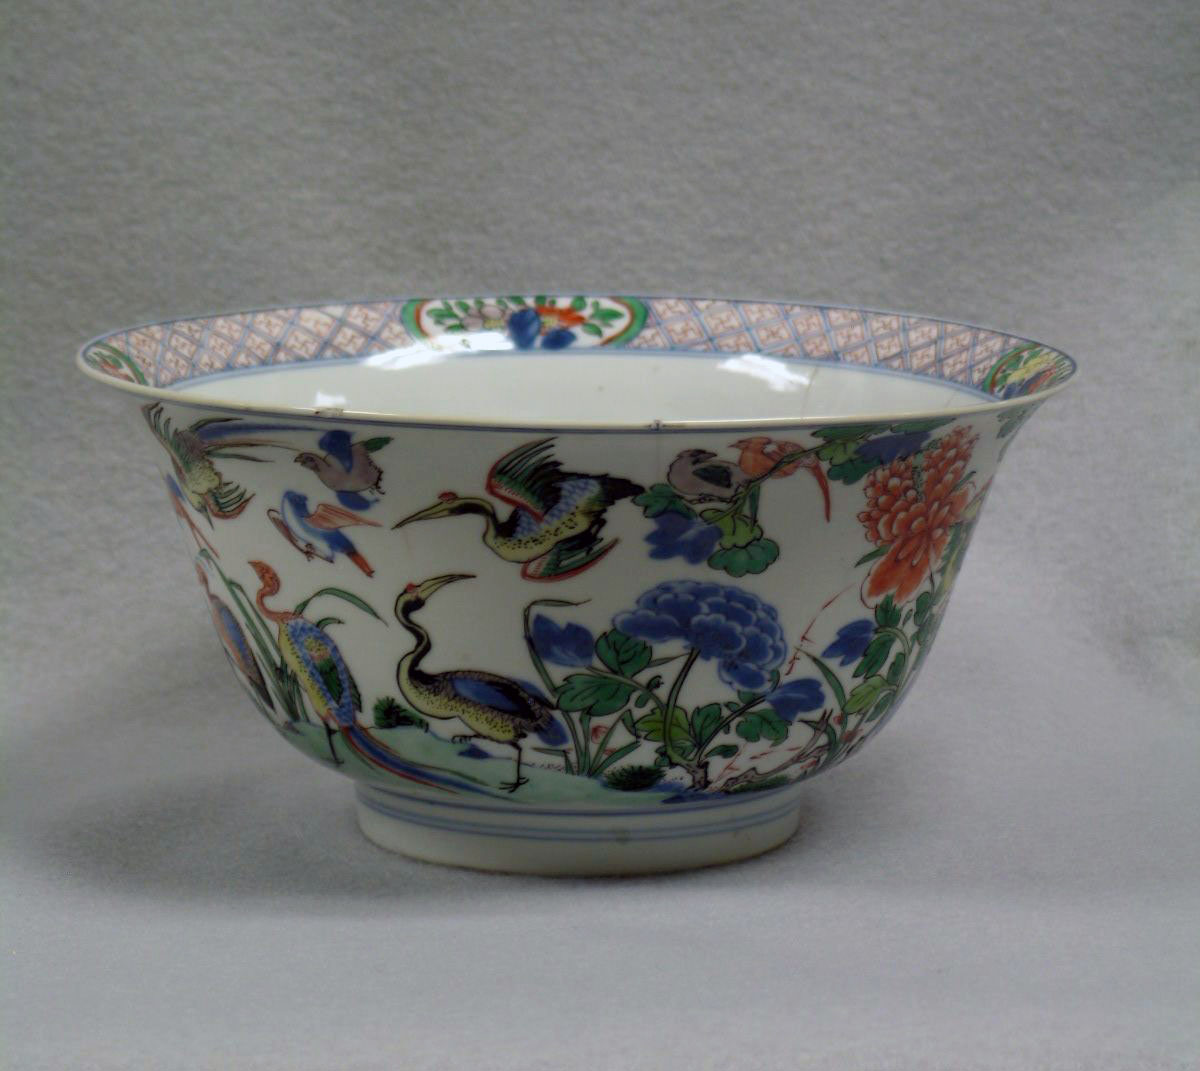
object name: bowl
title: Bowl with geese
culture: chinese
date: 1644-1911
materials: enamel, porcelain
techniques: overglaze, painting, underglaze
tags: birds,flowers